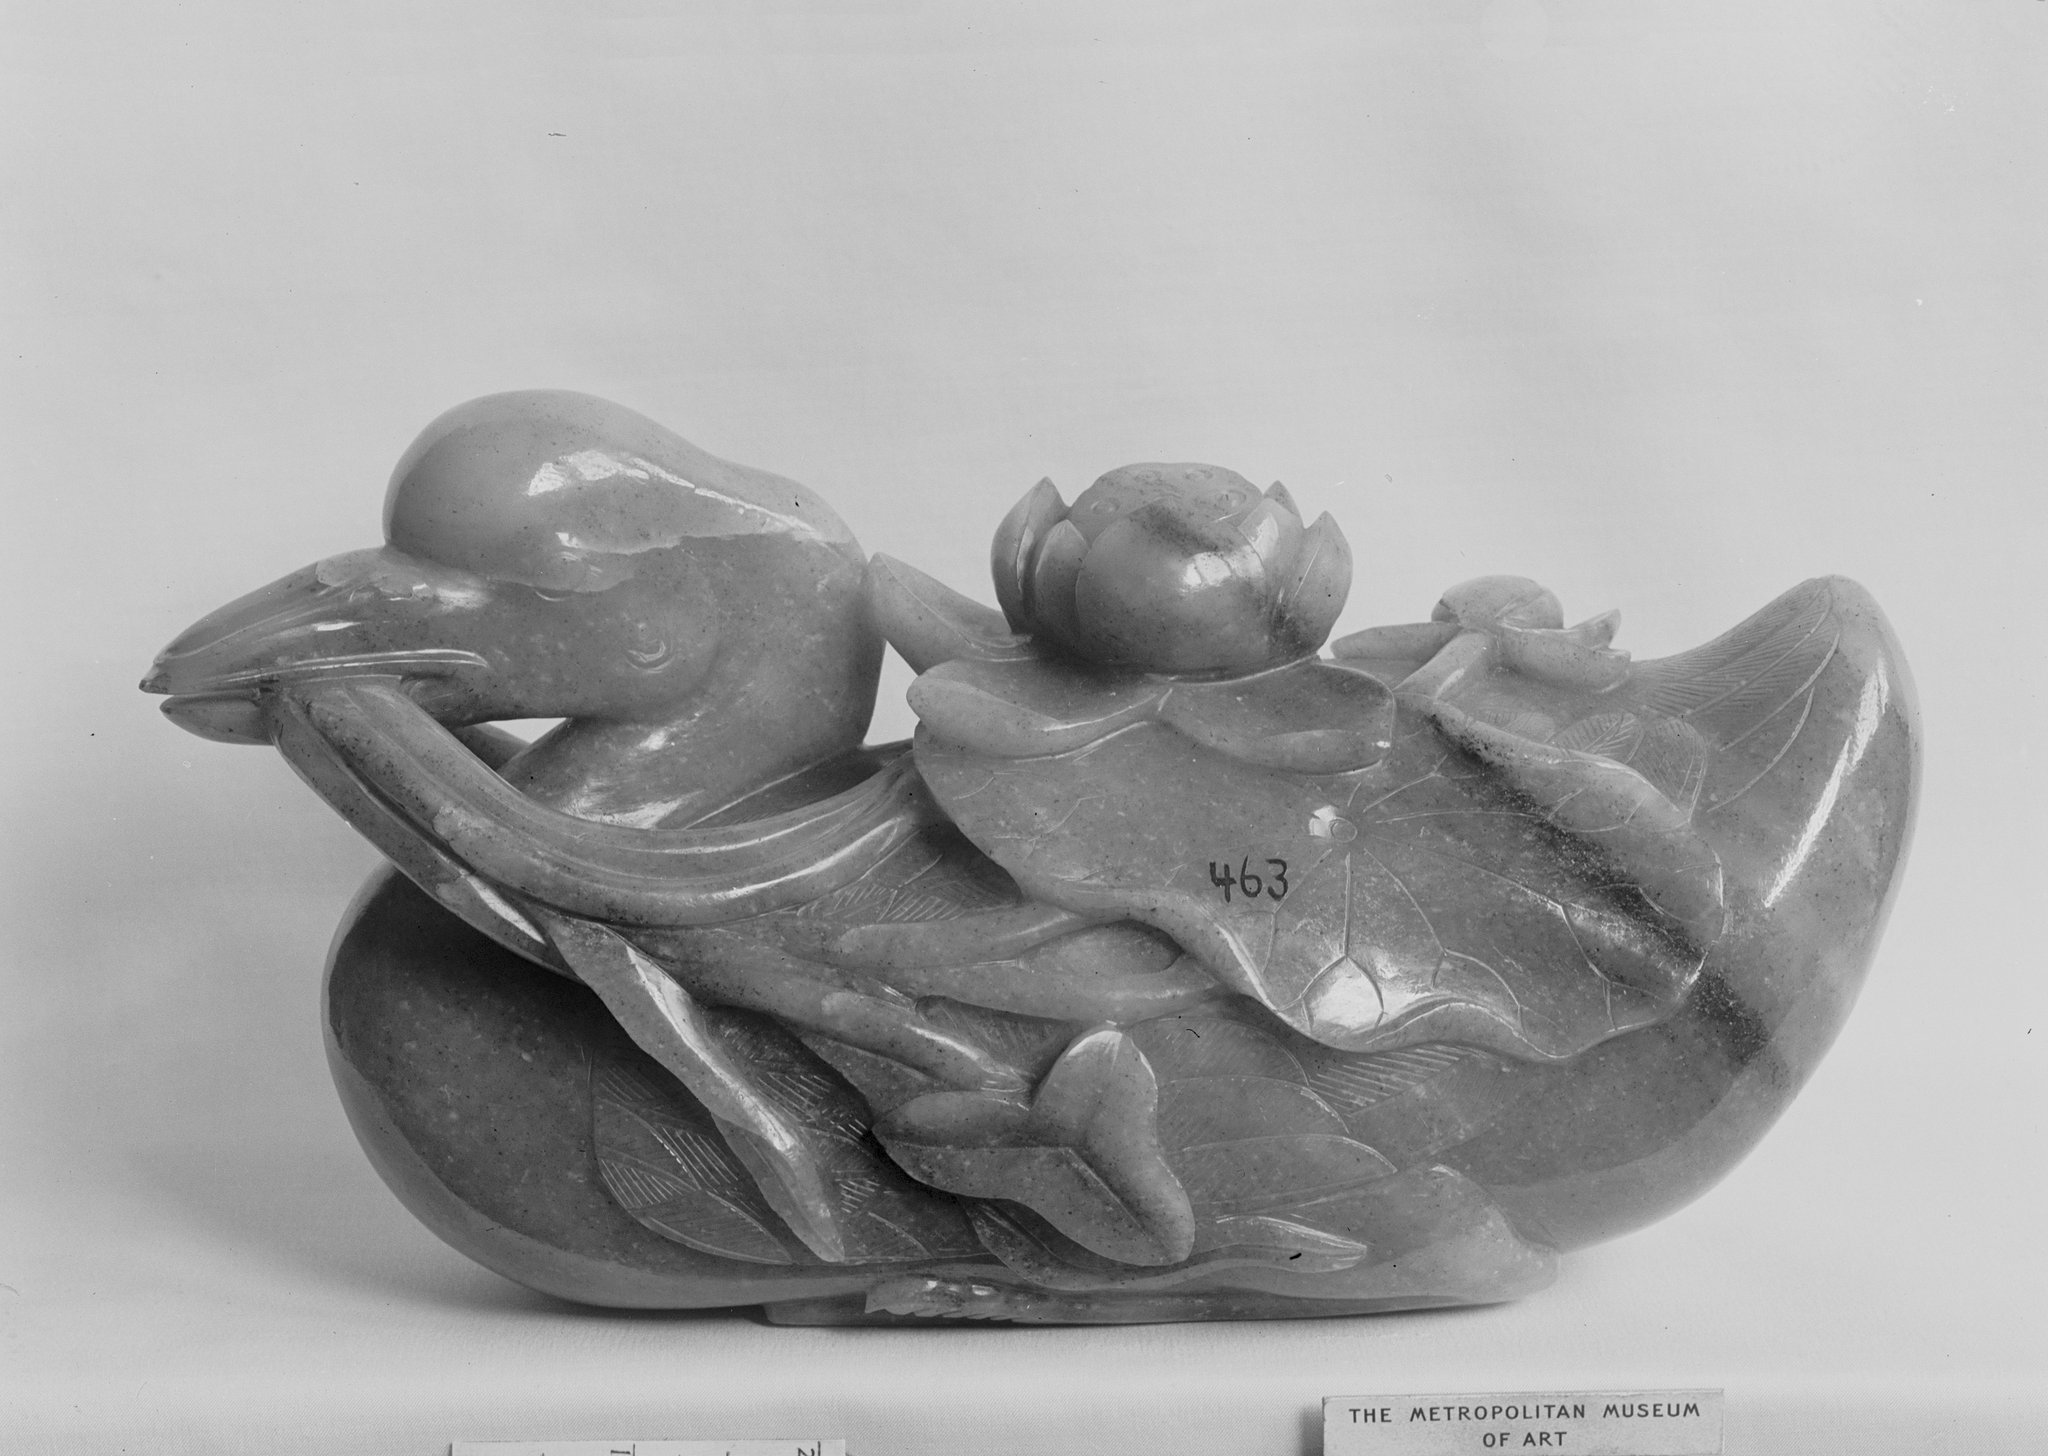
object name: figurine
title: Duck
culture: chinese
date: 1662-1722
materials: jade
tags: ducks